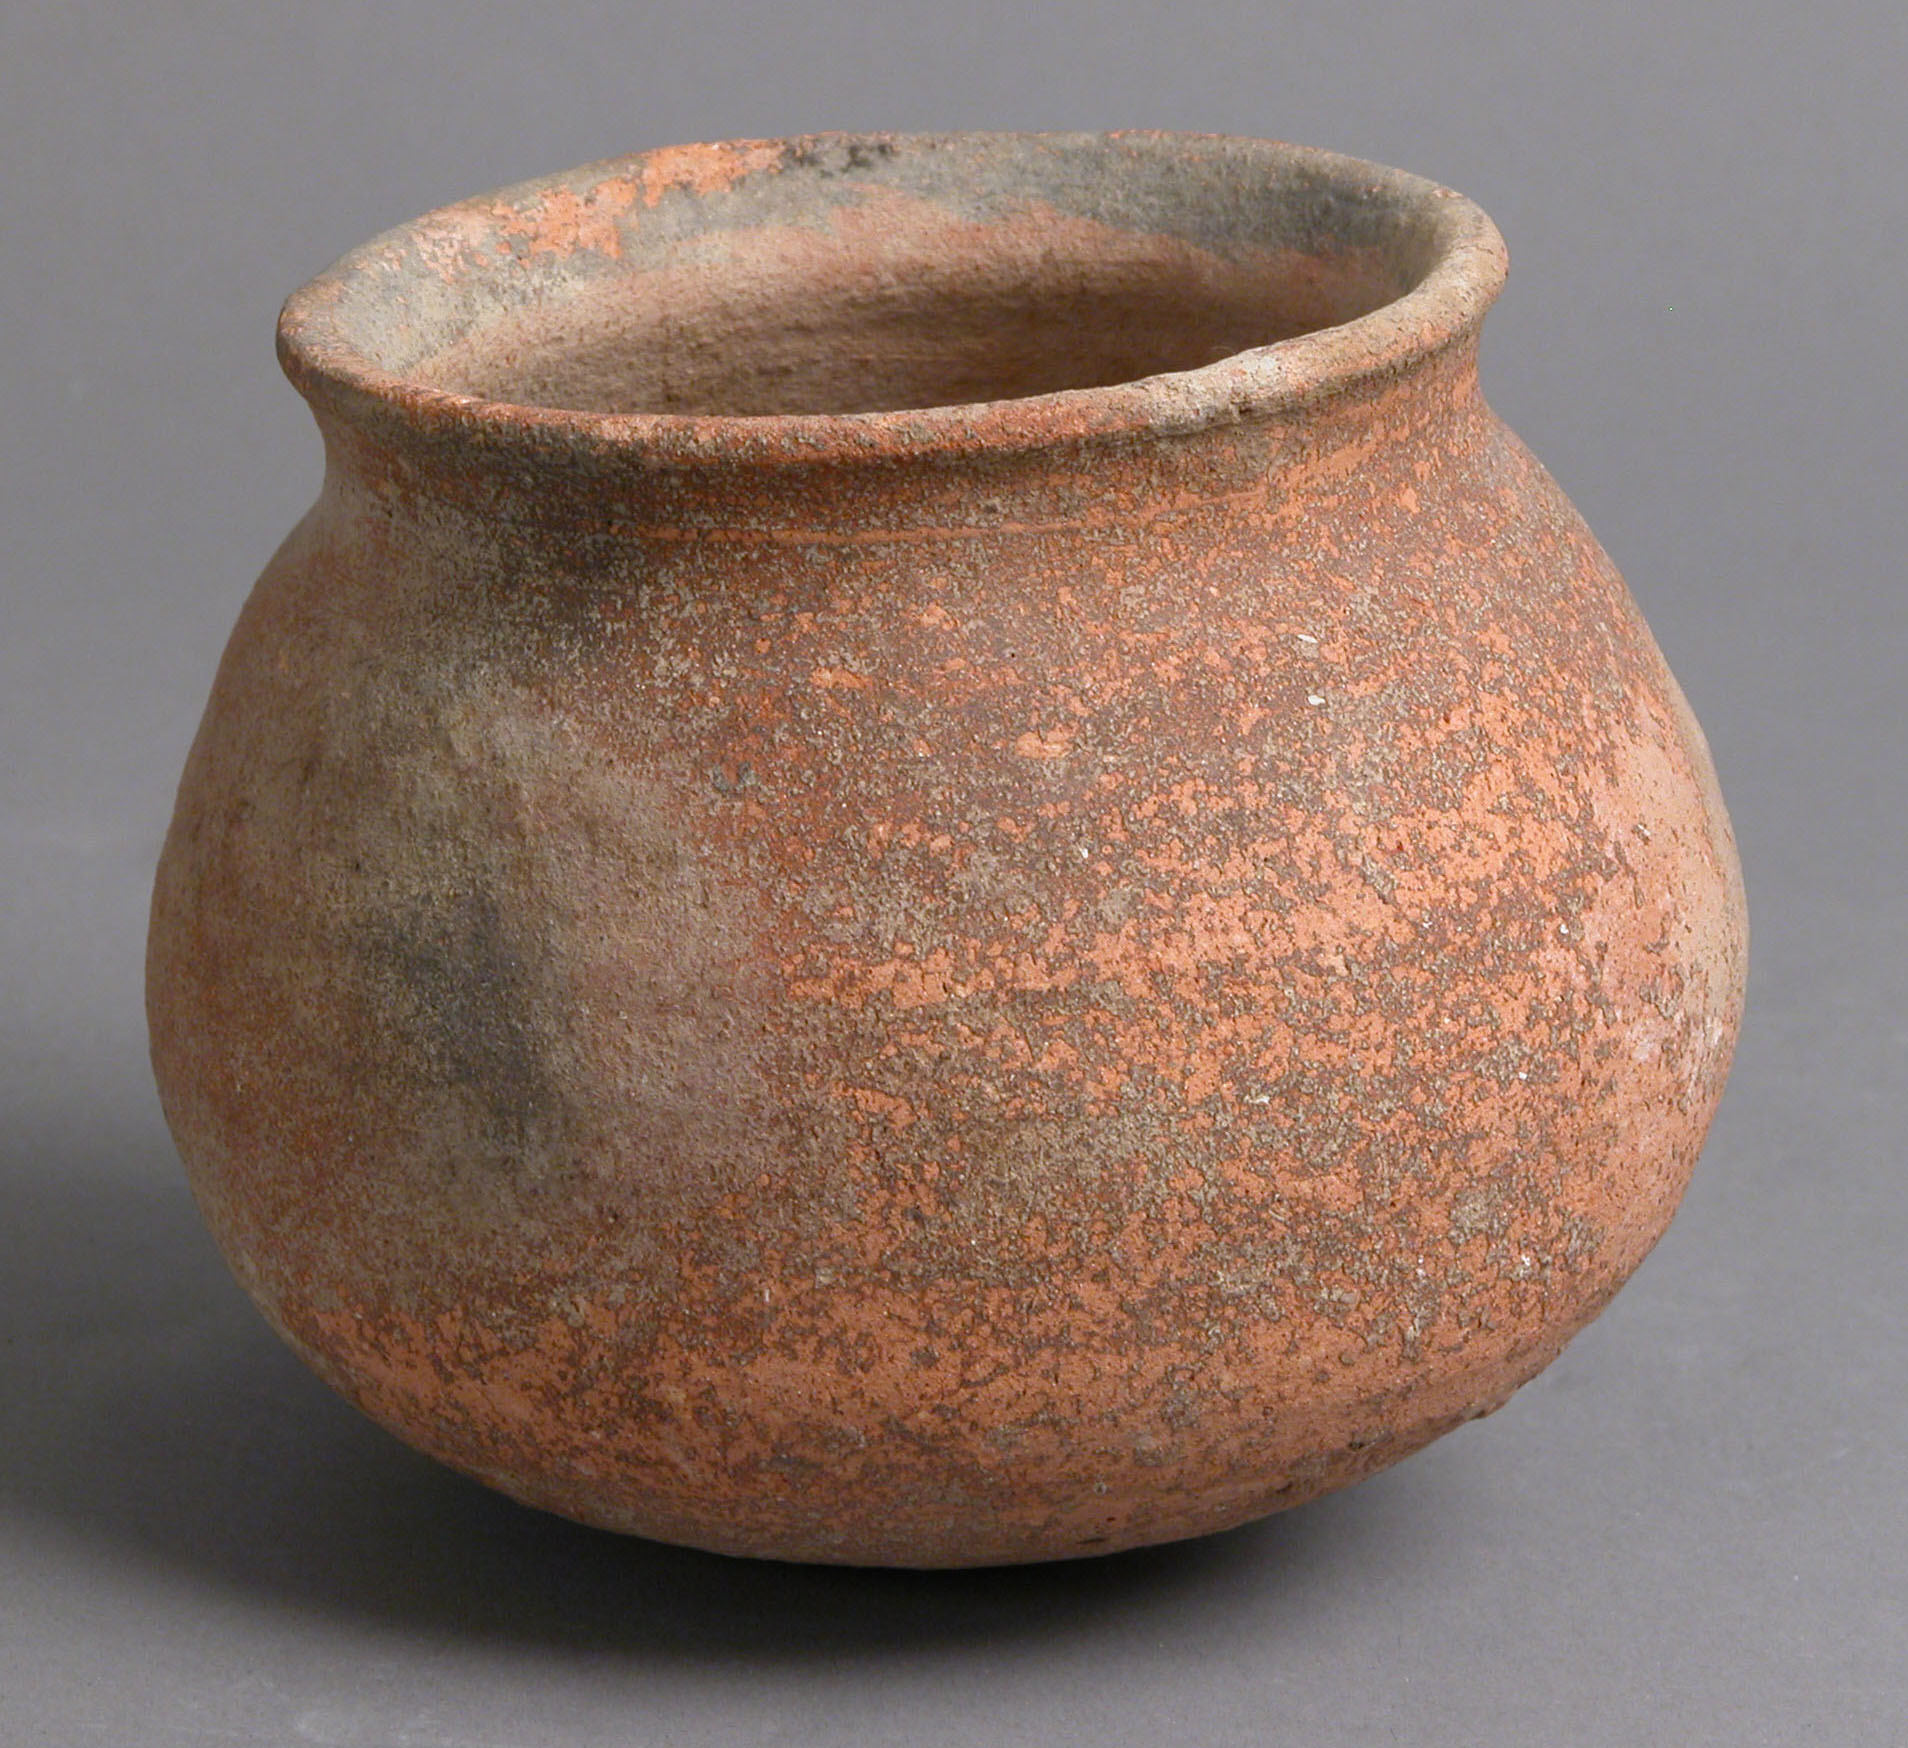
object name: pot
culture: coptic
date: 301-700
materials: earthenware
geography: egypt